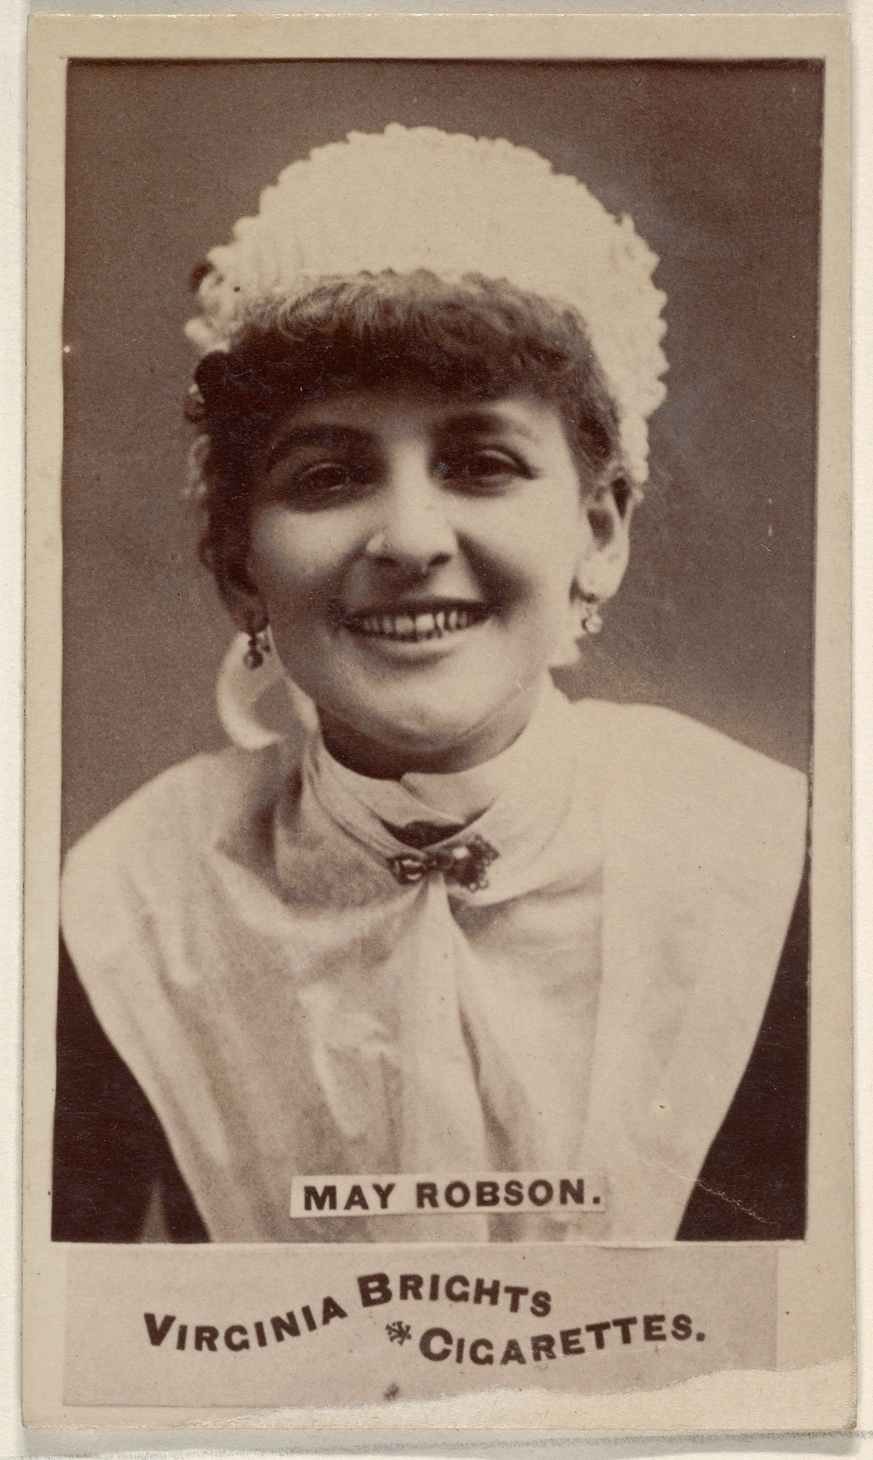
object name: photograph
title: May Robson, from the Actors and Actresses series (N45, Type 6) for Virginia Brights Cigarettes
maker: allen & ginter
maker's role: publisher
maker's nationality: american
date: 1888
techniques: albumen silver print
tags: portraits,women,actresses